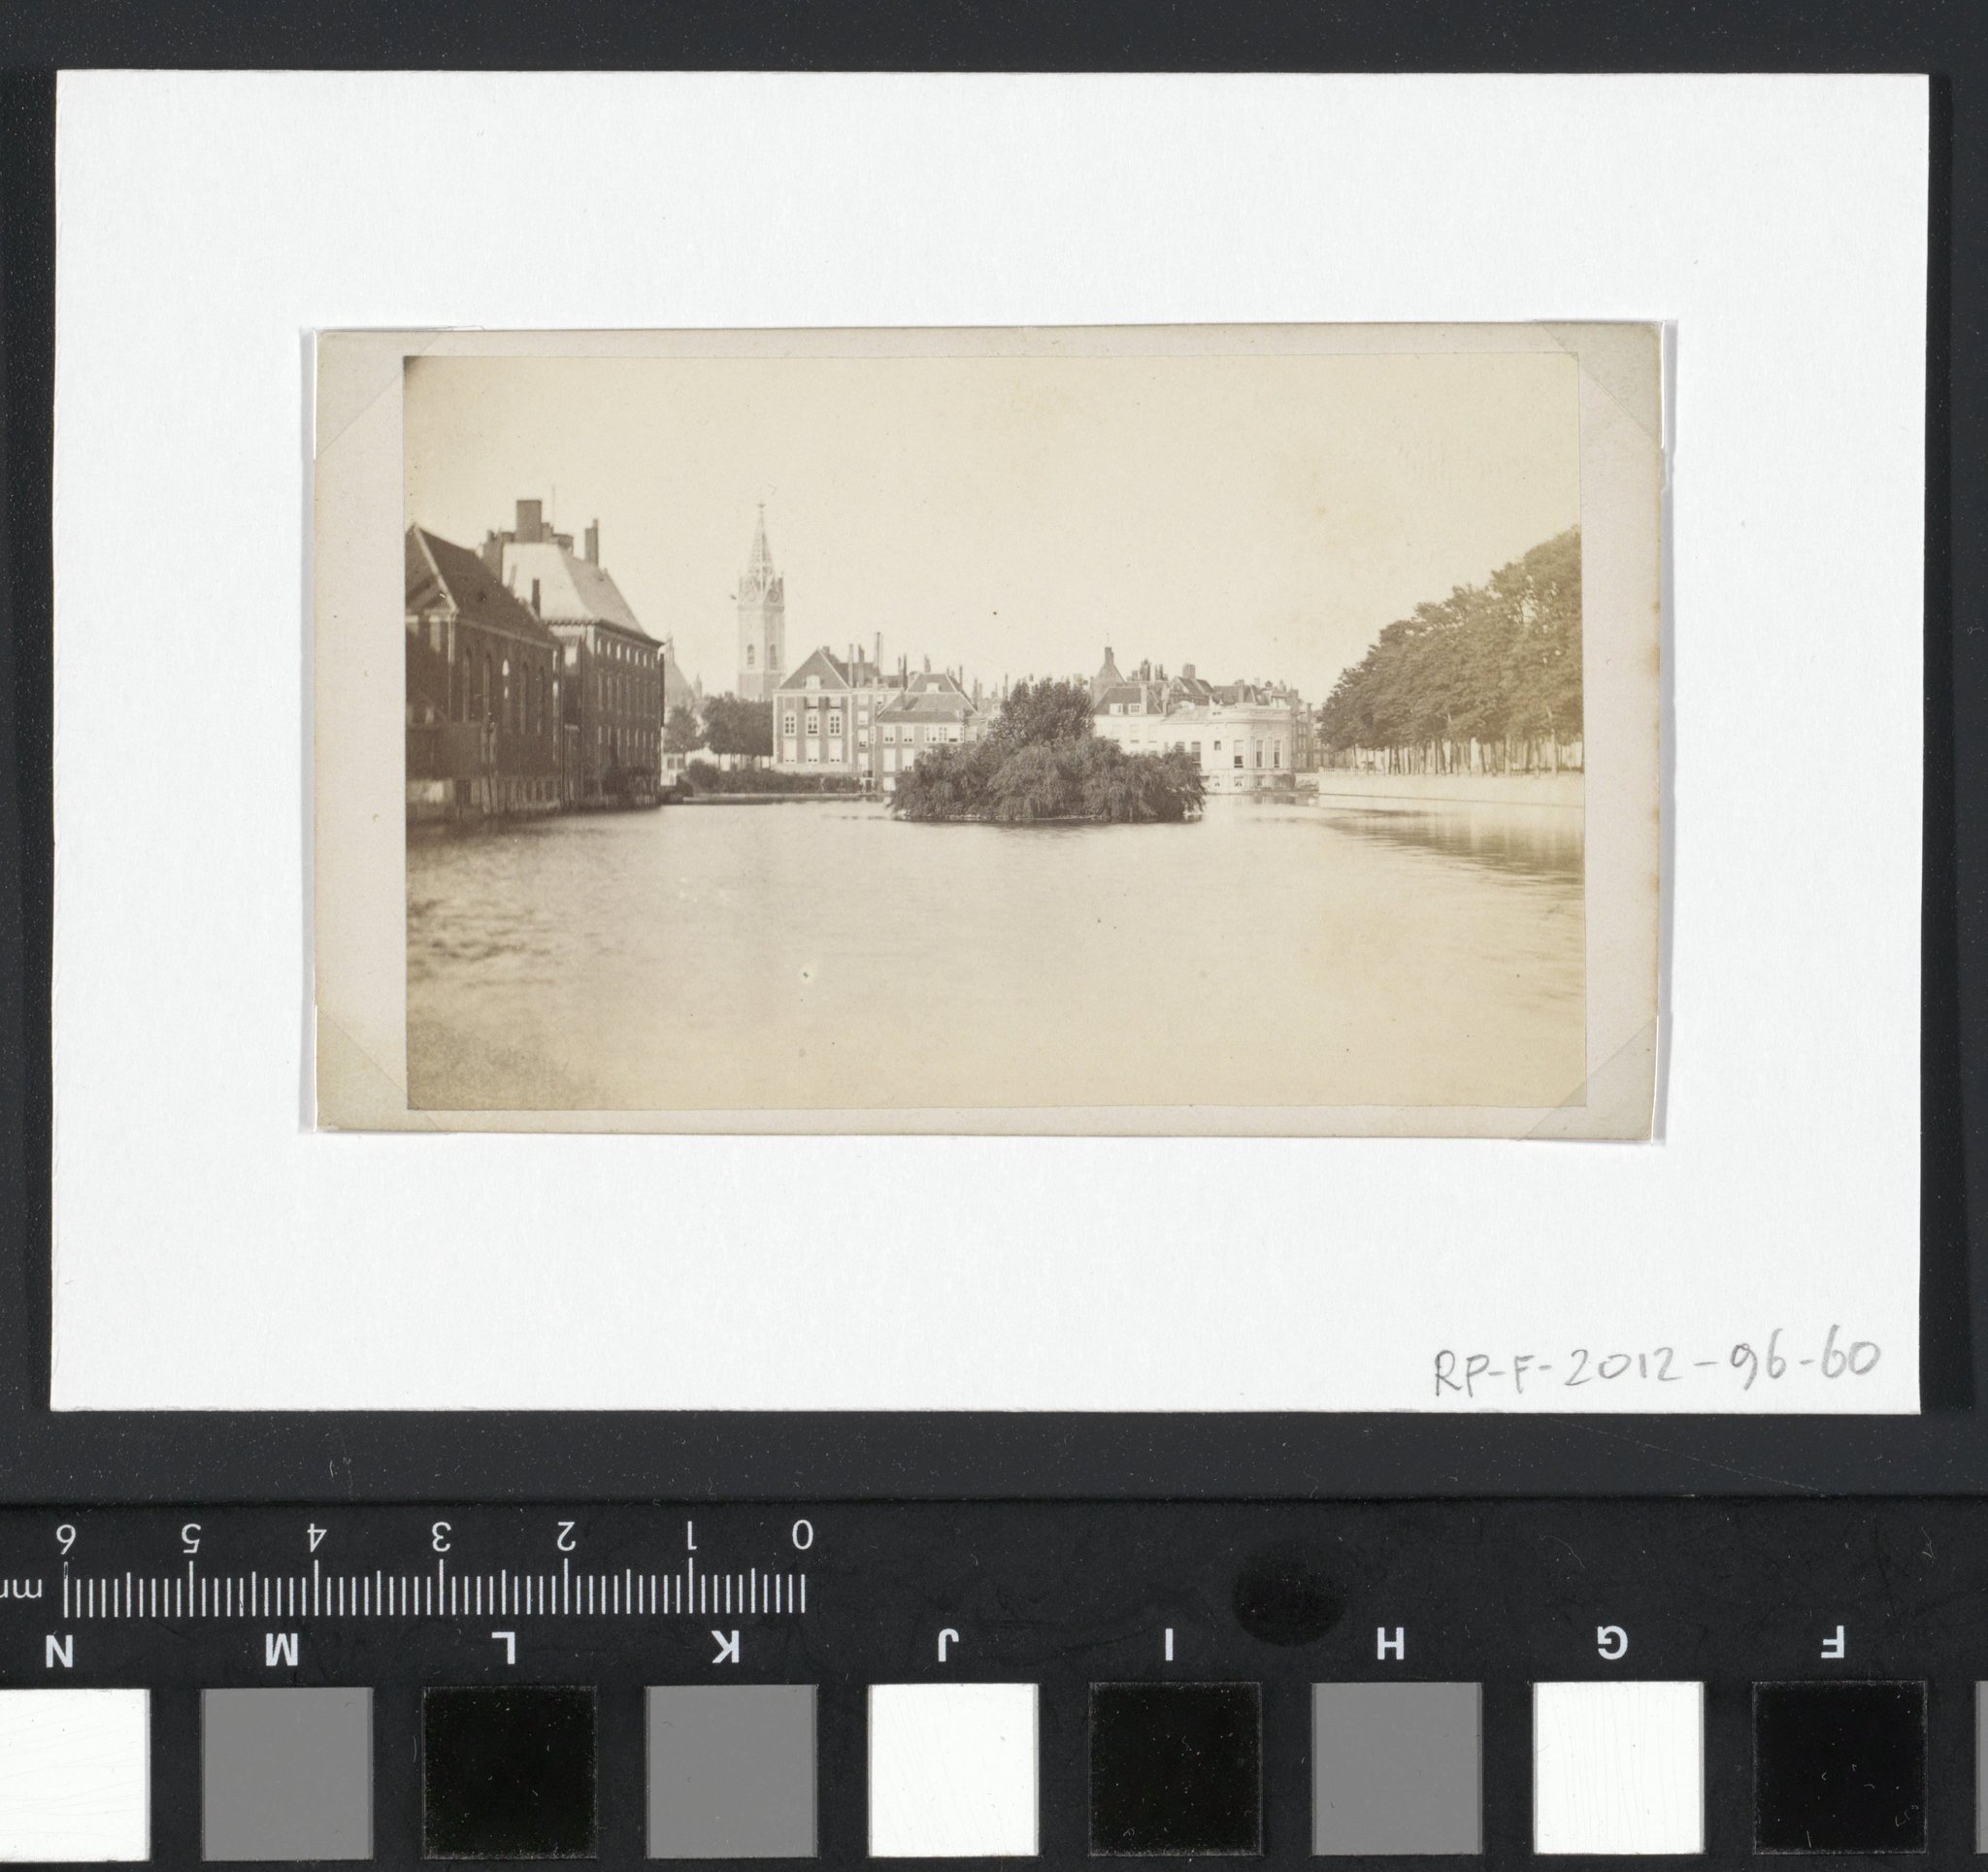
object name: photograph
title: Gezicht op de Hofvijver en de gebouwen er omheen in Den Haag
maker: Anonymous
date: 1860-1880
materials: cardboard, paper, photographic support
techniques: albumen print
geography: the hague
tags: pond